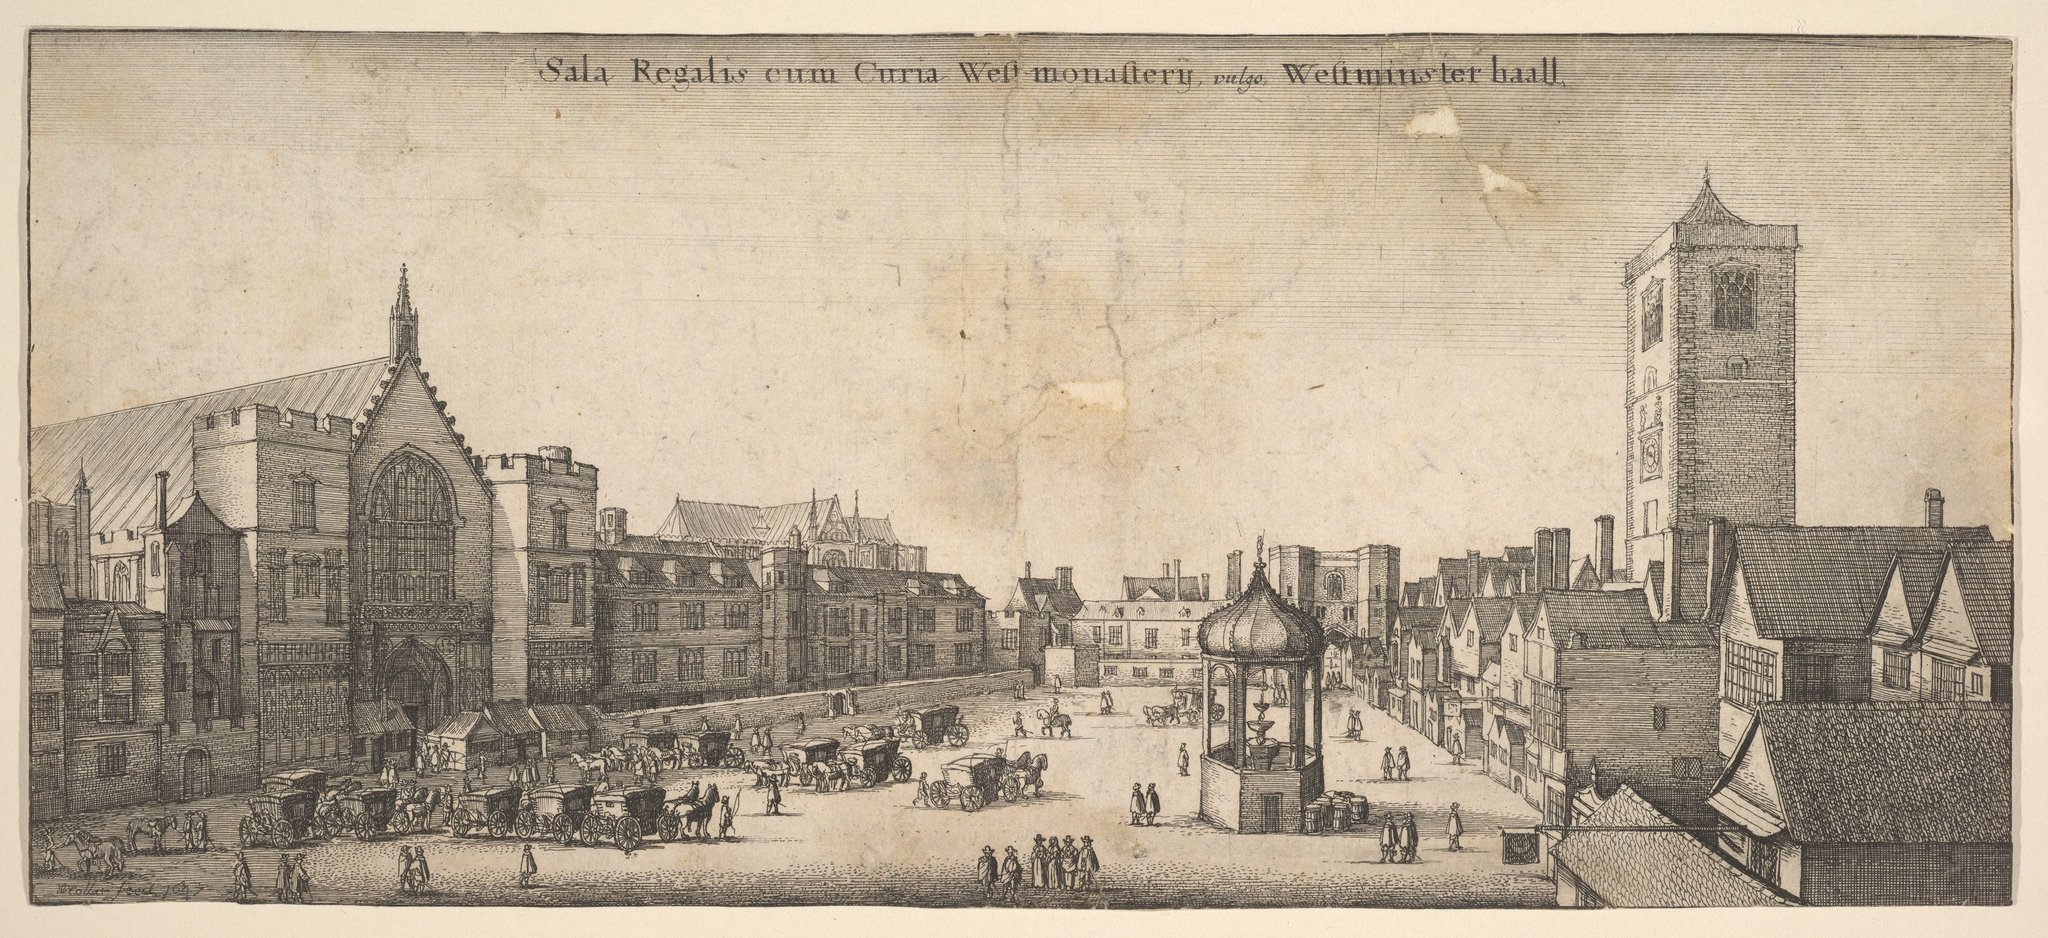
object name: print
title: Sala Regalis cum Curia West-monasterÿ, vulgo Westminster haal (Westminster Hall)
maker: wenceslaus hollar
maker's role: artist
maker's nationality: bohemian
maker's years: 1607-1677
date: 1647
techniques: etching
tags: buildings,fountains,streets,crowd,carriages